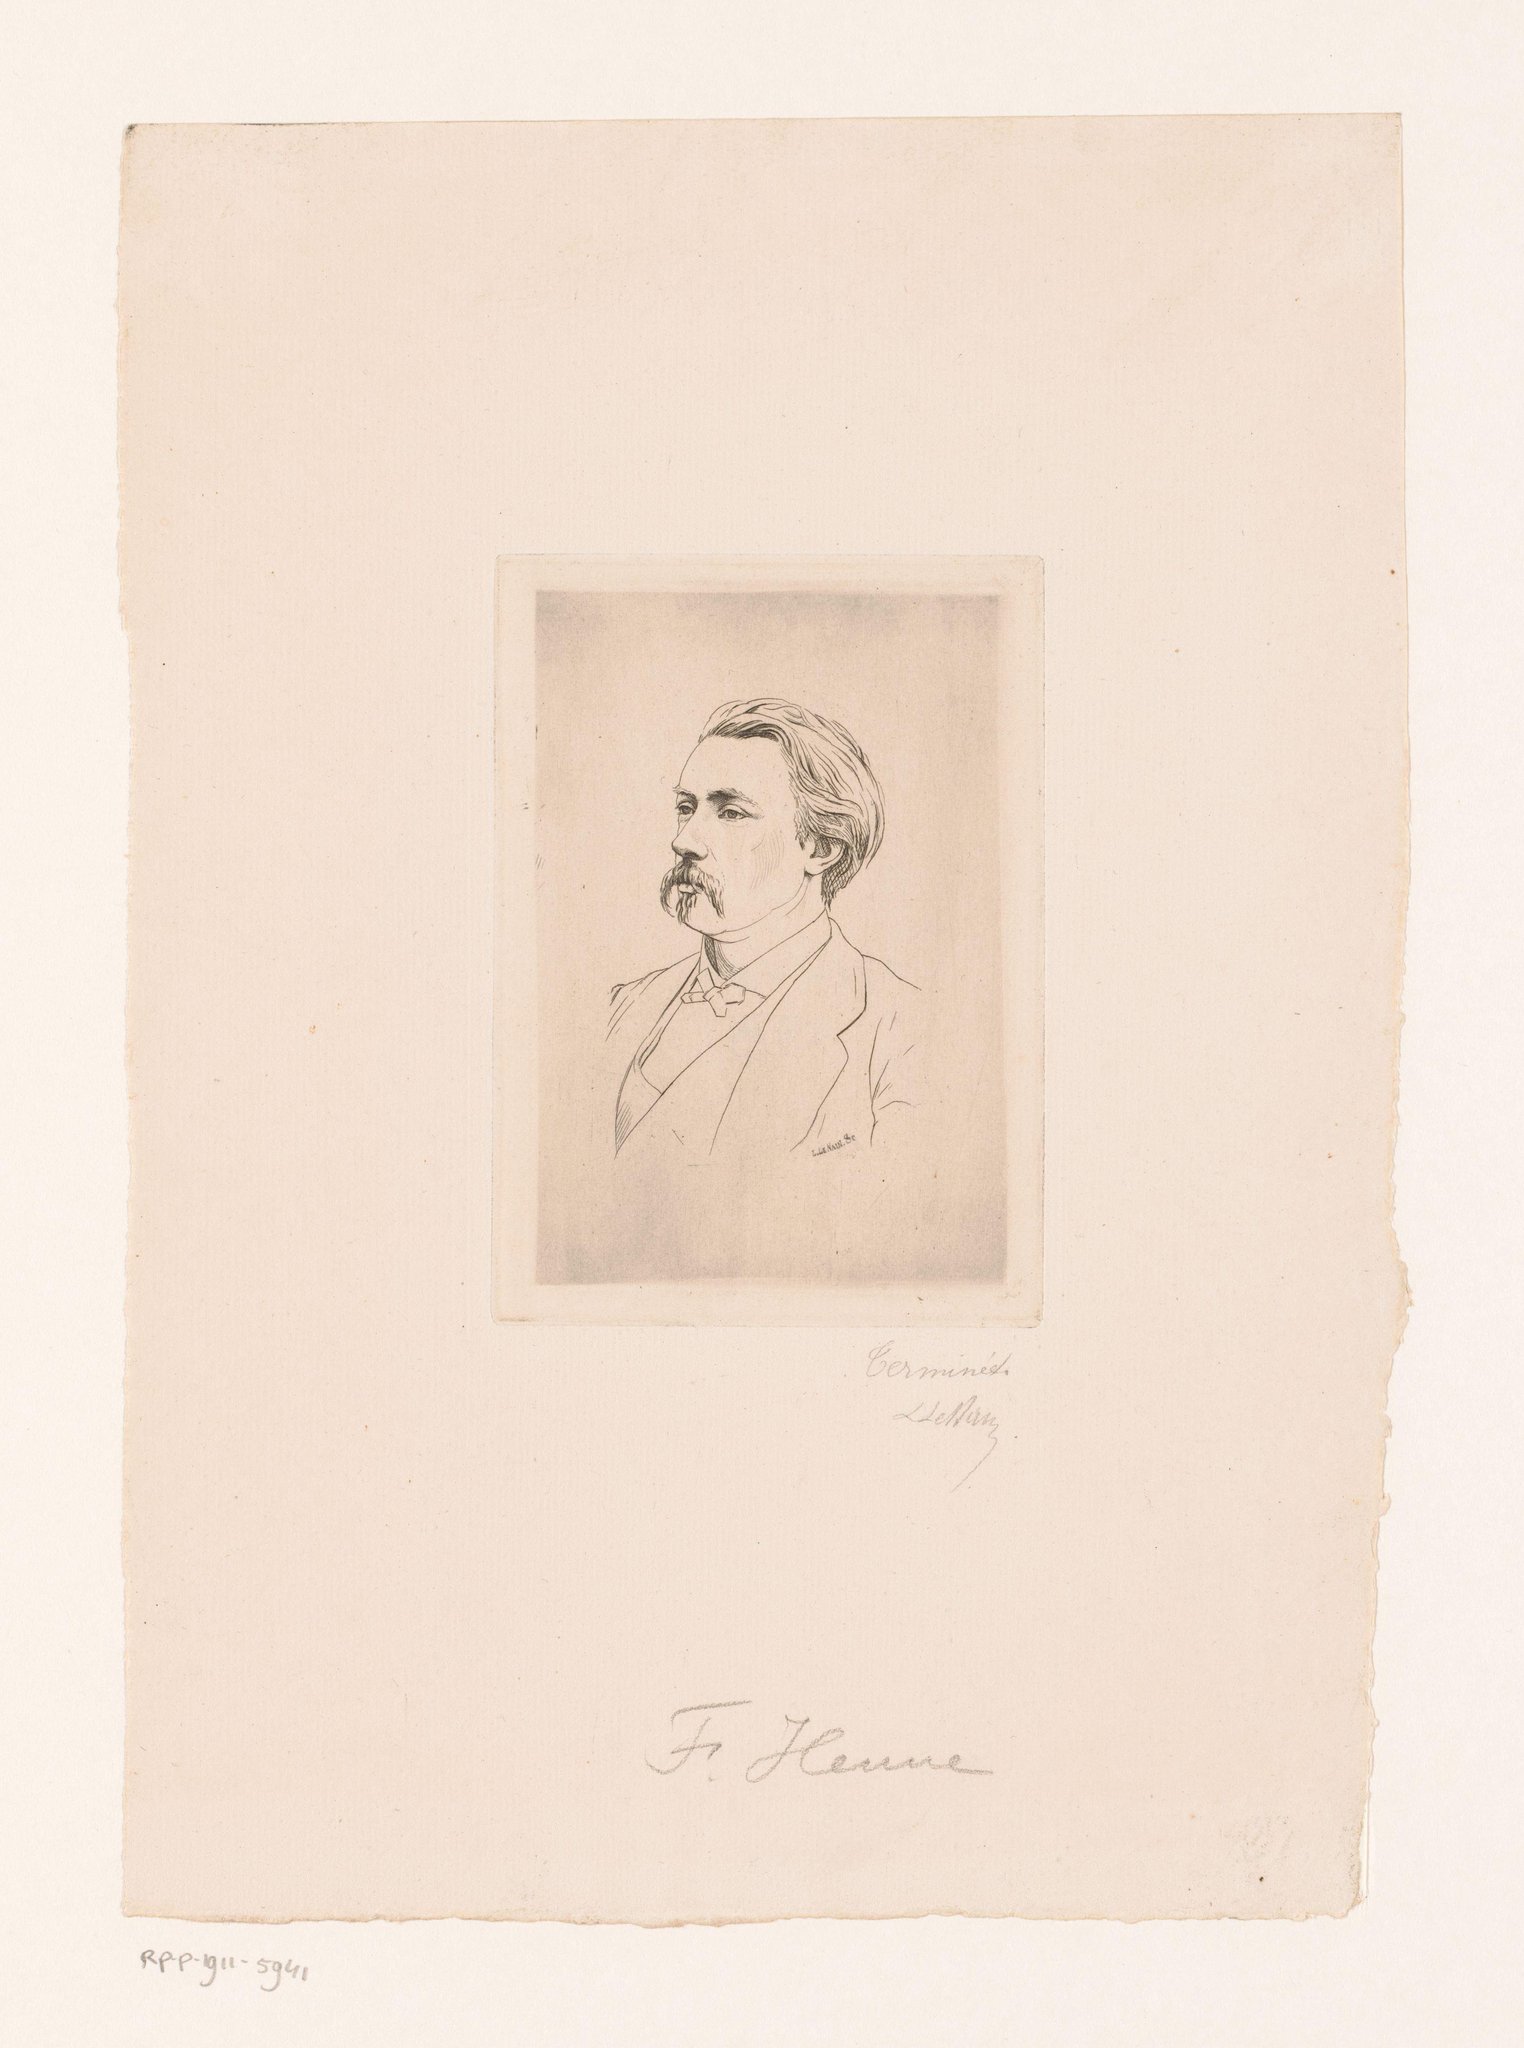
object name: print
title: Portret van een onbekende man, mogelijk F. Henne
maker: louis le nain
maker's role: print maker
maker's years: 1851-1939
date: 1861-1911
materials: paper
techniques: etching, intaglio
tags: moustache, adult man, historical persons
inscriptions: inscription: ‘Terminée LLe Nain’, collector's mark: Lugt 2228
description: Opschrift op object in potlood: F. Henne.